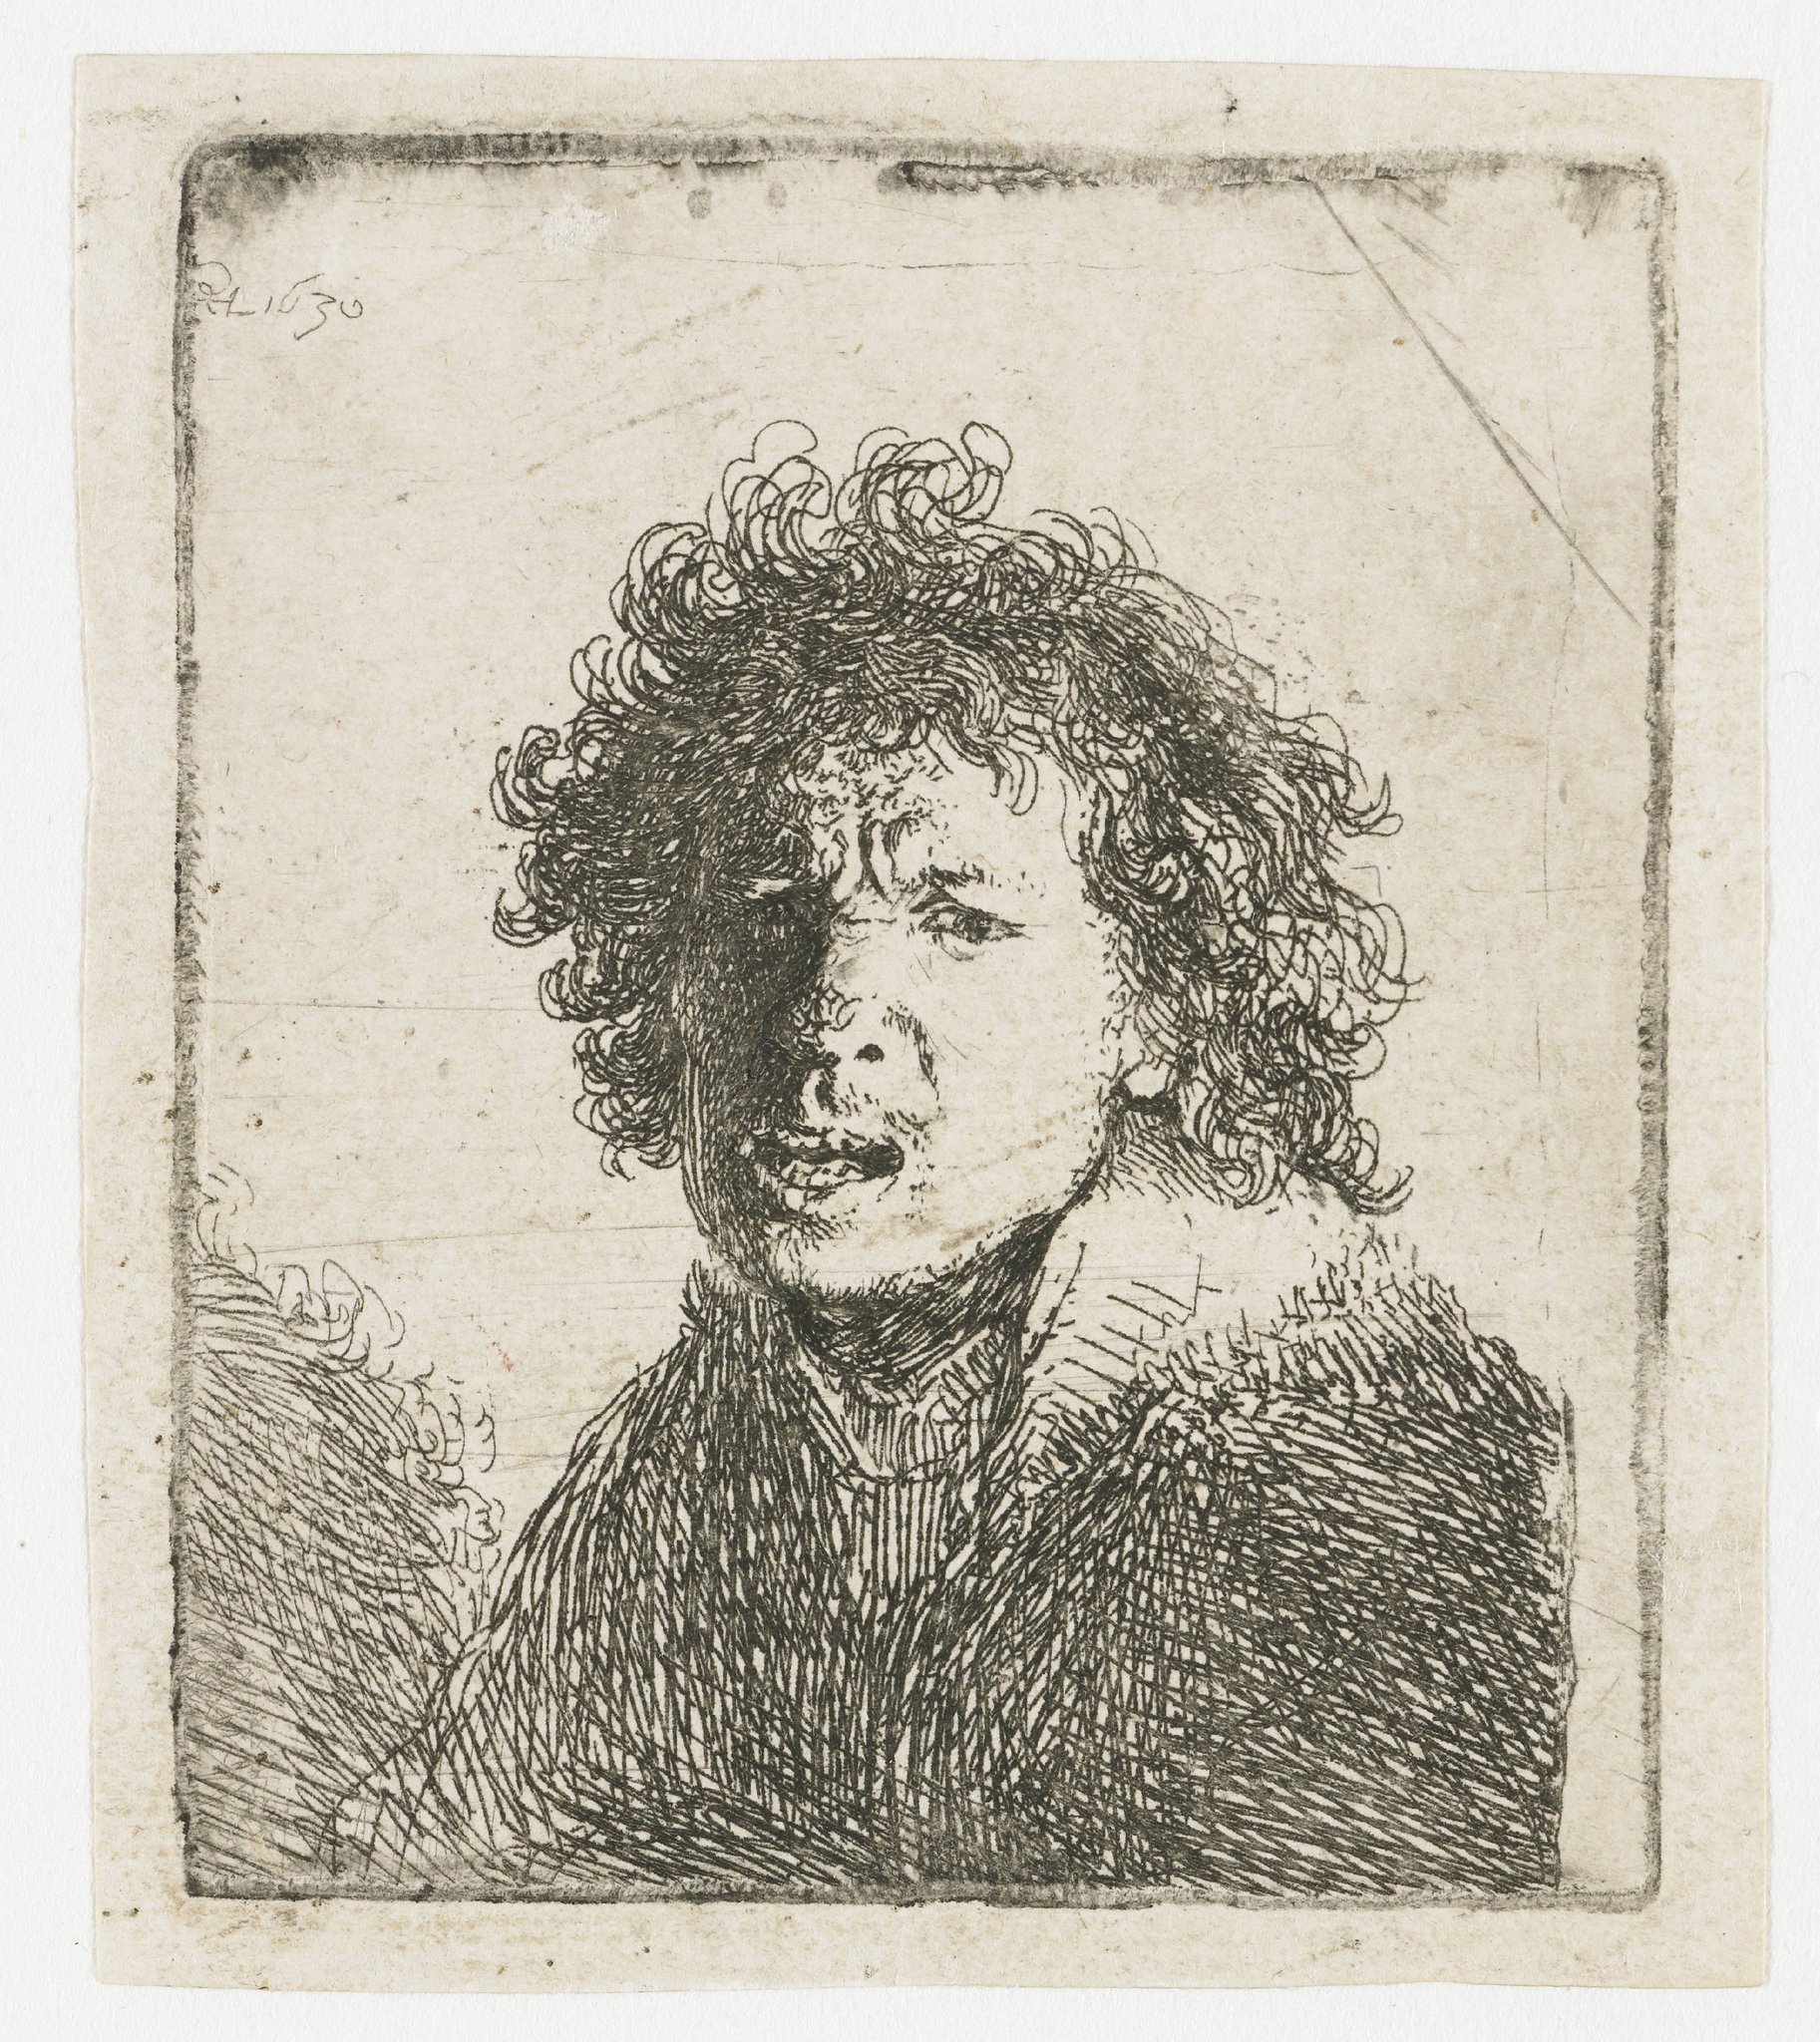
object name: print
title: Self-portrait open mouthed, as if shouting: bust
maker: rembrandt van rijn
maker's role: draughtsman, painter, print maker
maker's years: 1606-1669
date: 1630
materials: paper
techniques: etching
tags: leiden, amsterdam, painter, print maker, rembrandt van rijn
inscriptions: collector's mark: Lugt 240, monogram and date: ‘RHL 1630’